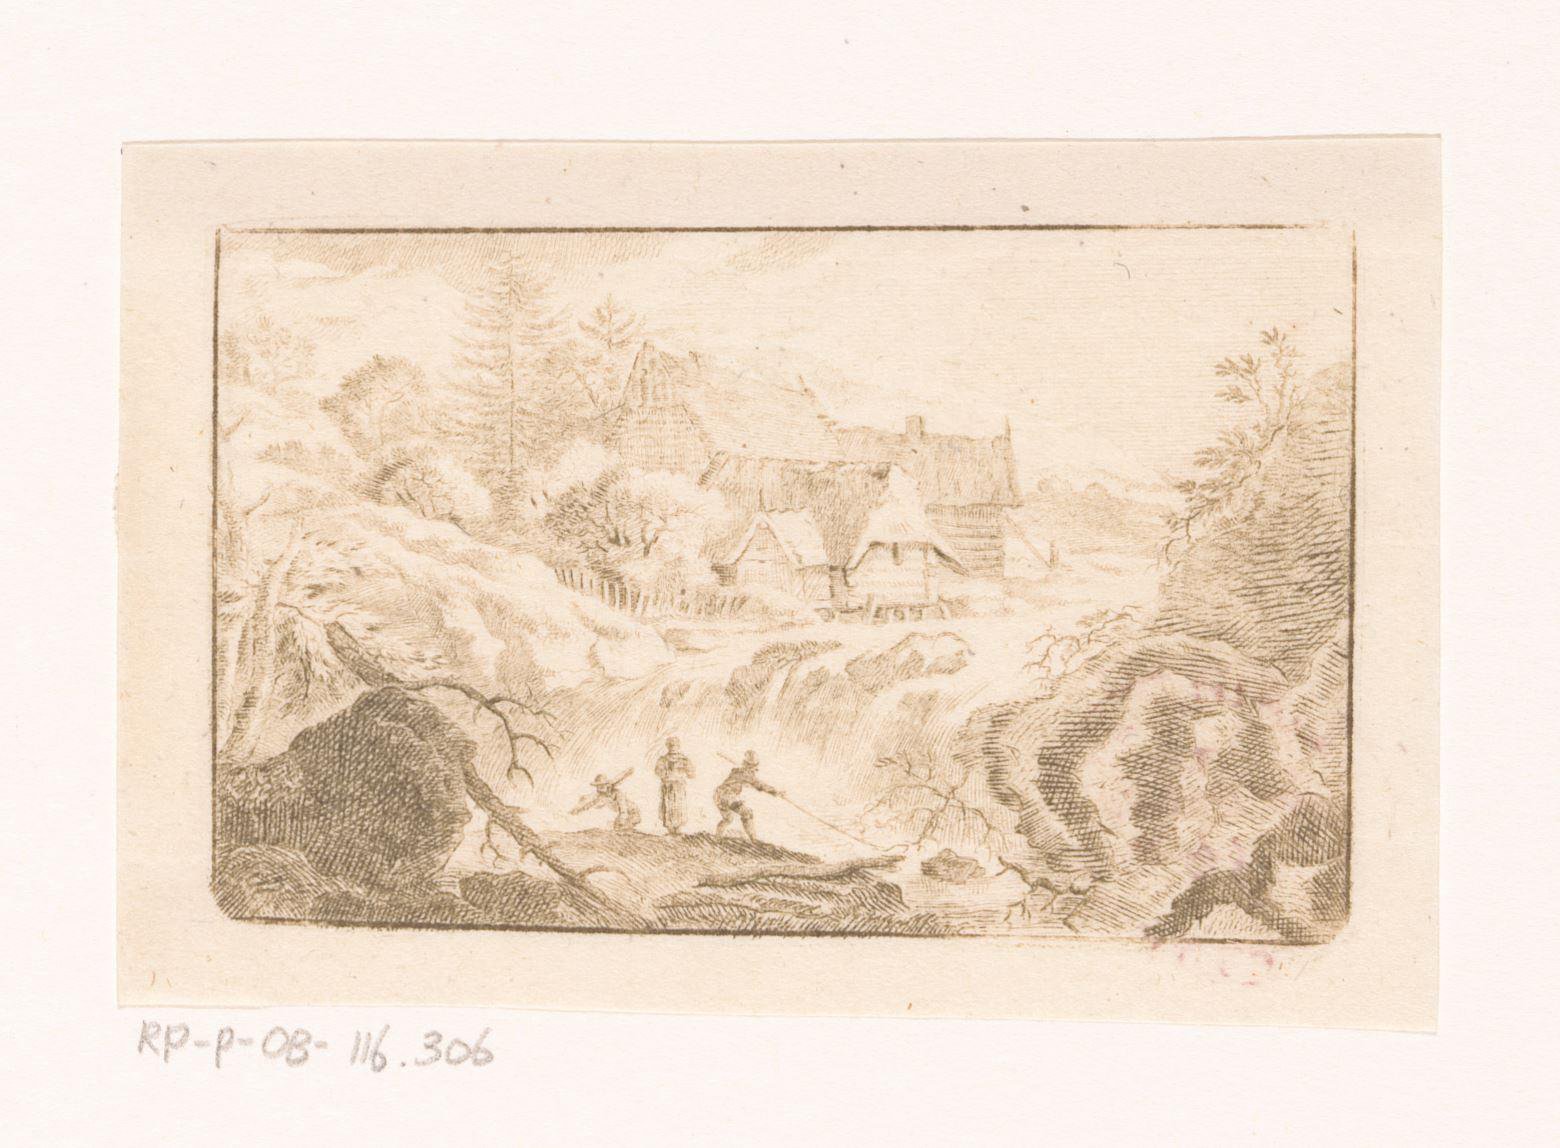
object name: print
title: Landschap met huizen achter een waterval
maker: carl friedrich holtzmann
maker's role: print maker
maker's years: 1740-1811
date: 1750-1811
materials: paper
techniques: printmaking, etching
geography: dresden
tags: landscapes, waterfall, hunt ~ other animals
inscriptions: collector's mark: Lugt 240